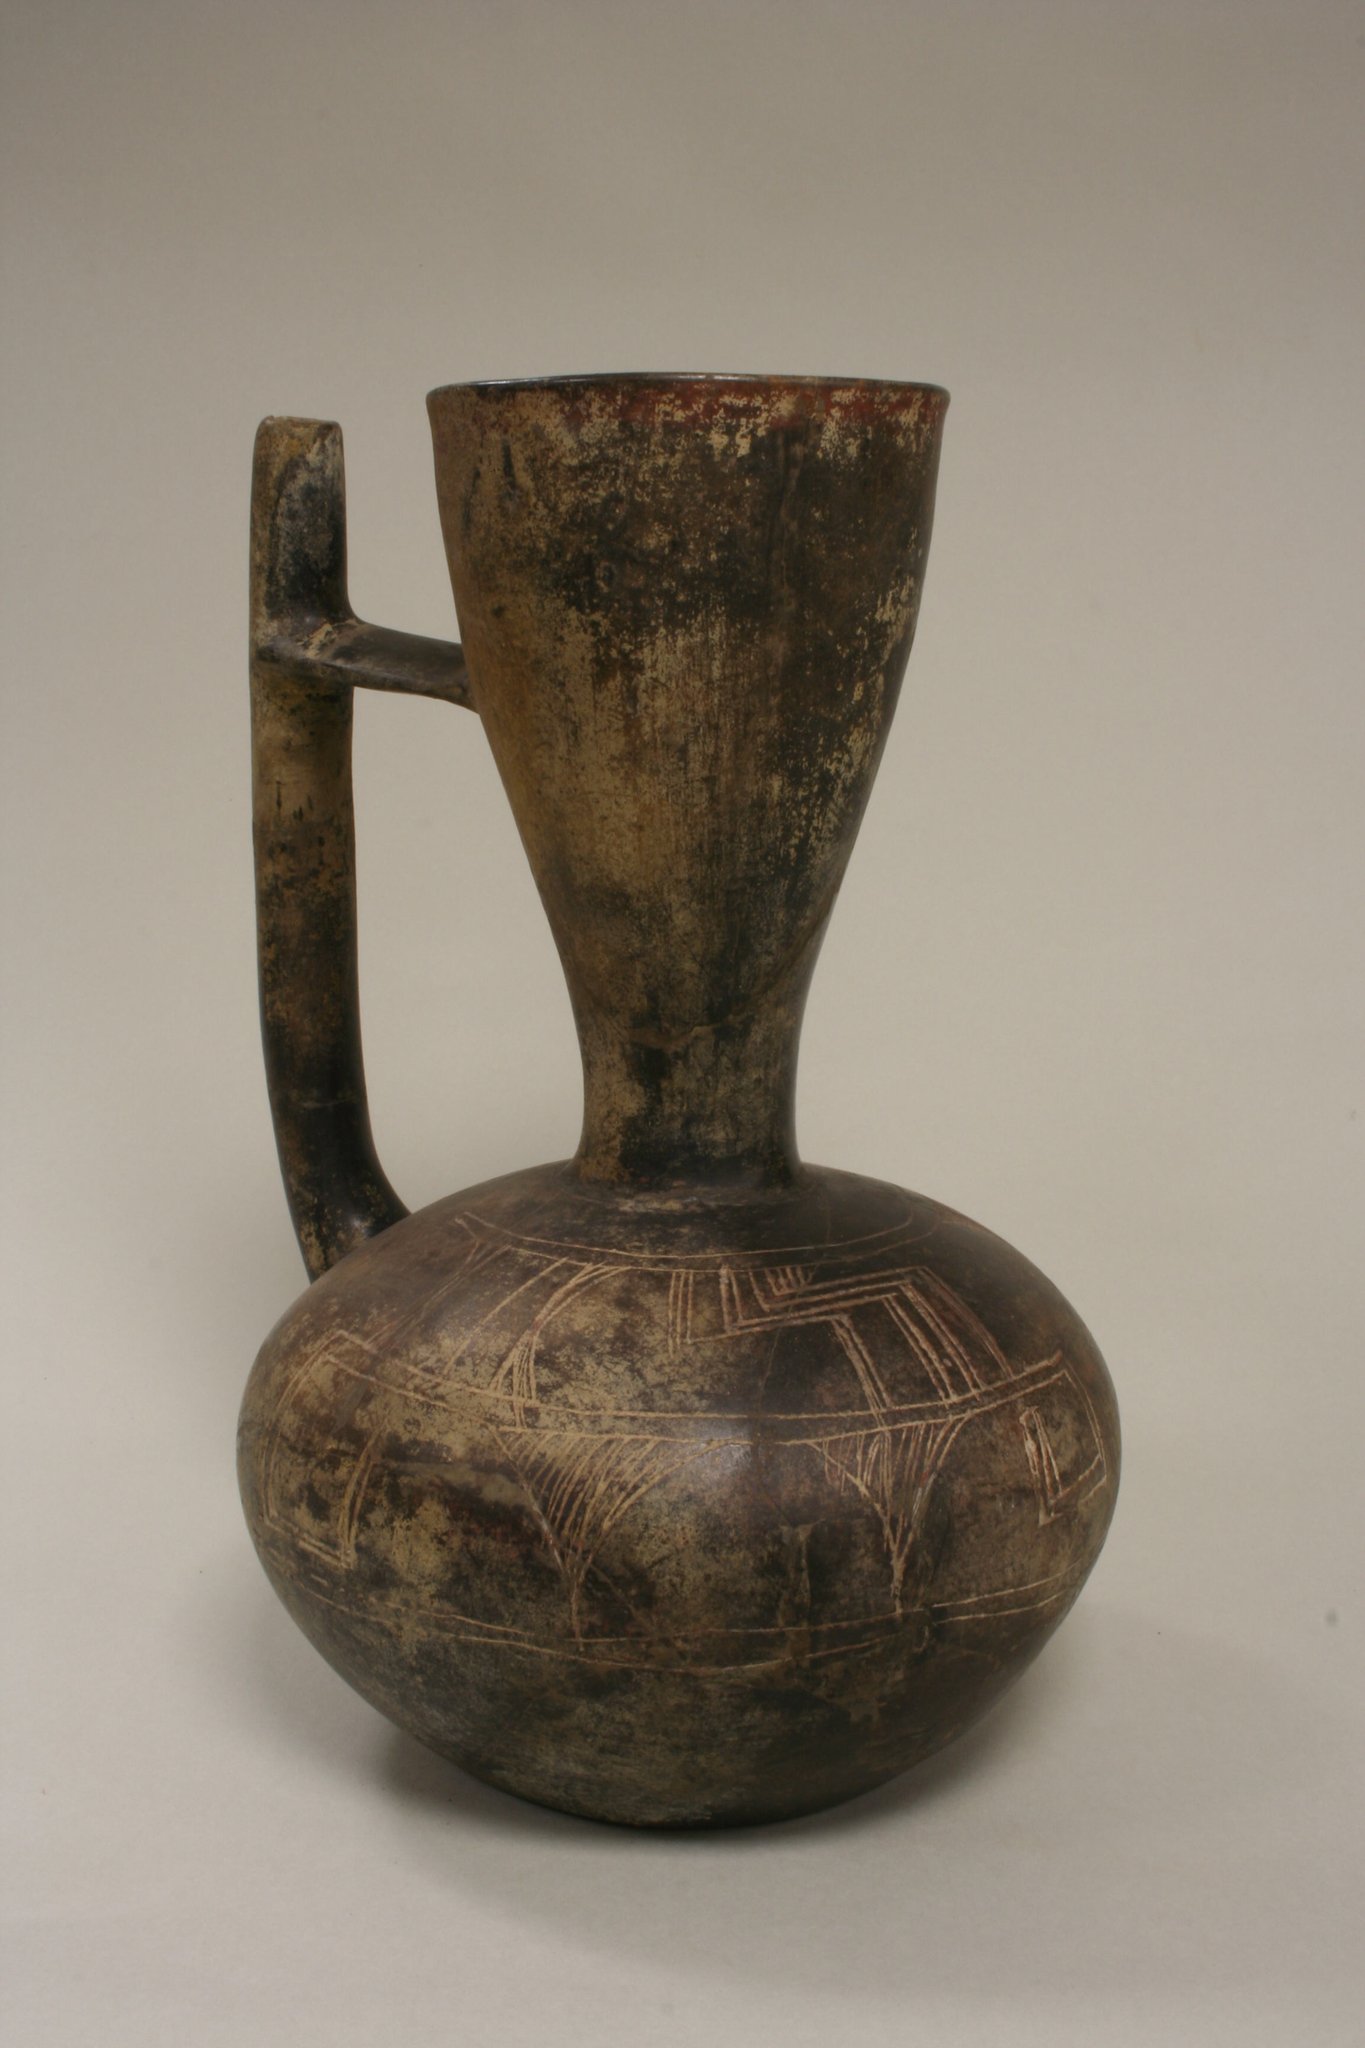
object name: bottle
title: Bridge and Spout Bottle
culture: monte alban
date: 200 BCE-400 CE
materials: ceramic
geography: mexico